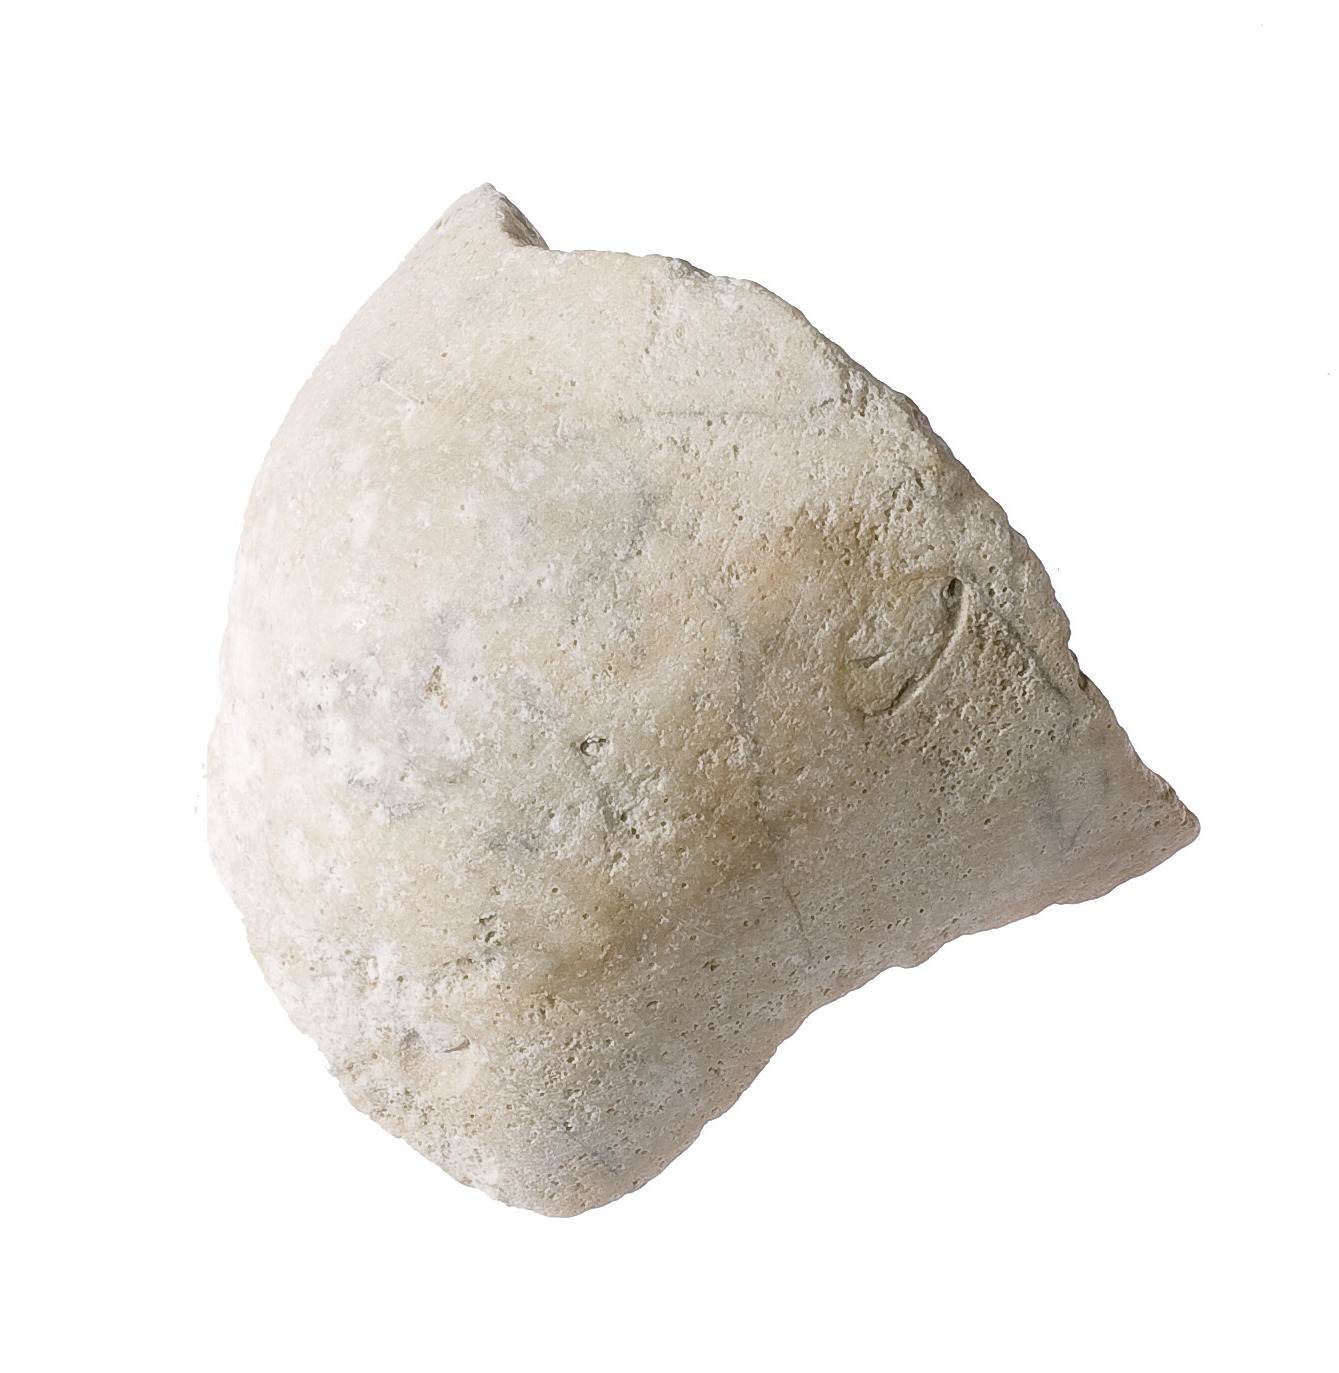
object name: elbow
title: Elbow (?)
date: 1353-1336 BCE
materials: limestone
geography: egypt